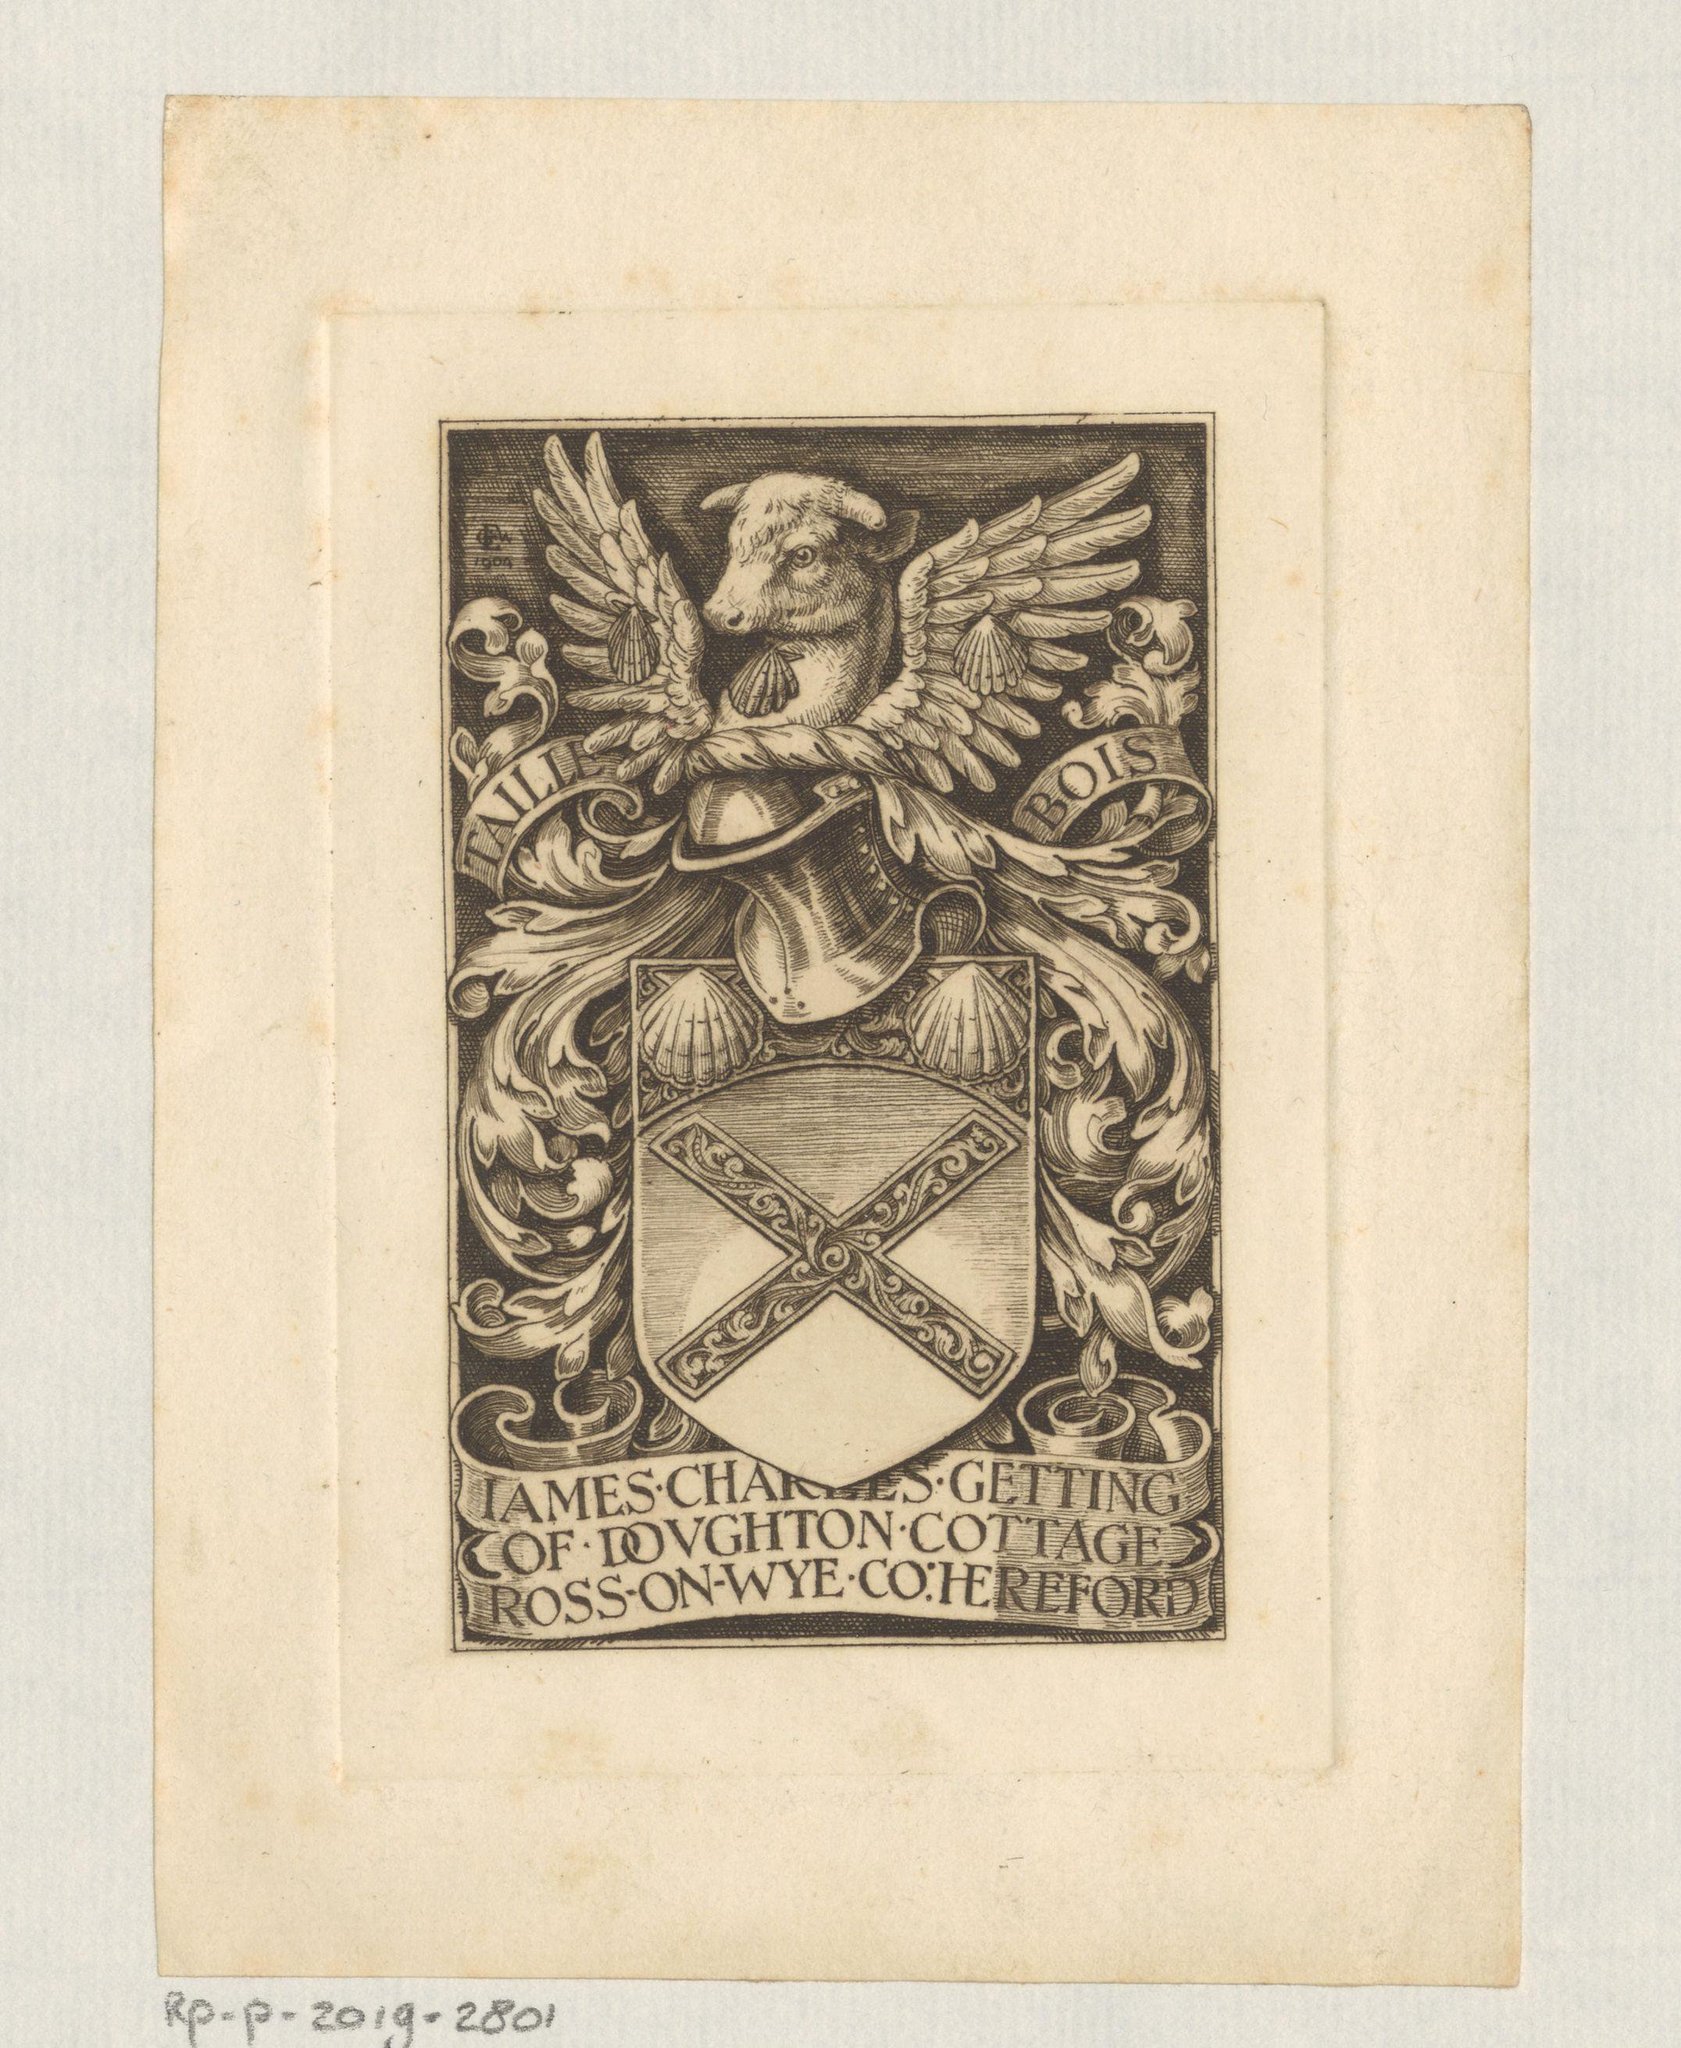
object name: bookplate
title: Ex libris van James Charles Getting of Doughton Cottage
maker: george william eve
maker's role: print maker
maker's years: 1855-1914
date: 1904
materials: paper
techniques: engraving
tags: armorial bearing, heraldry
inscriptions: date